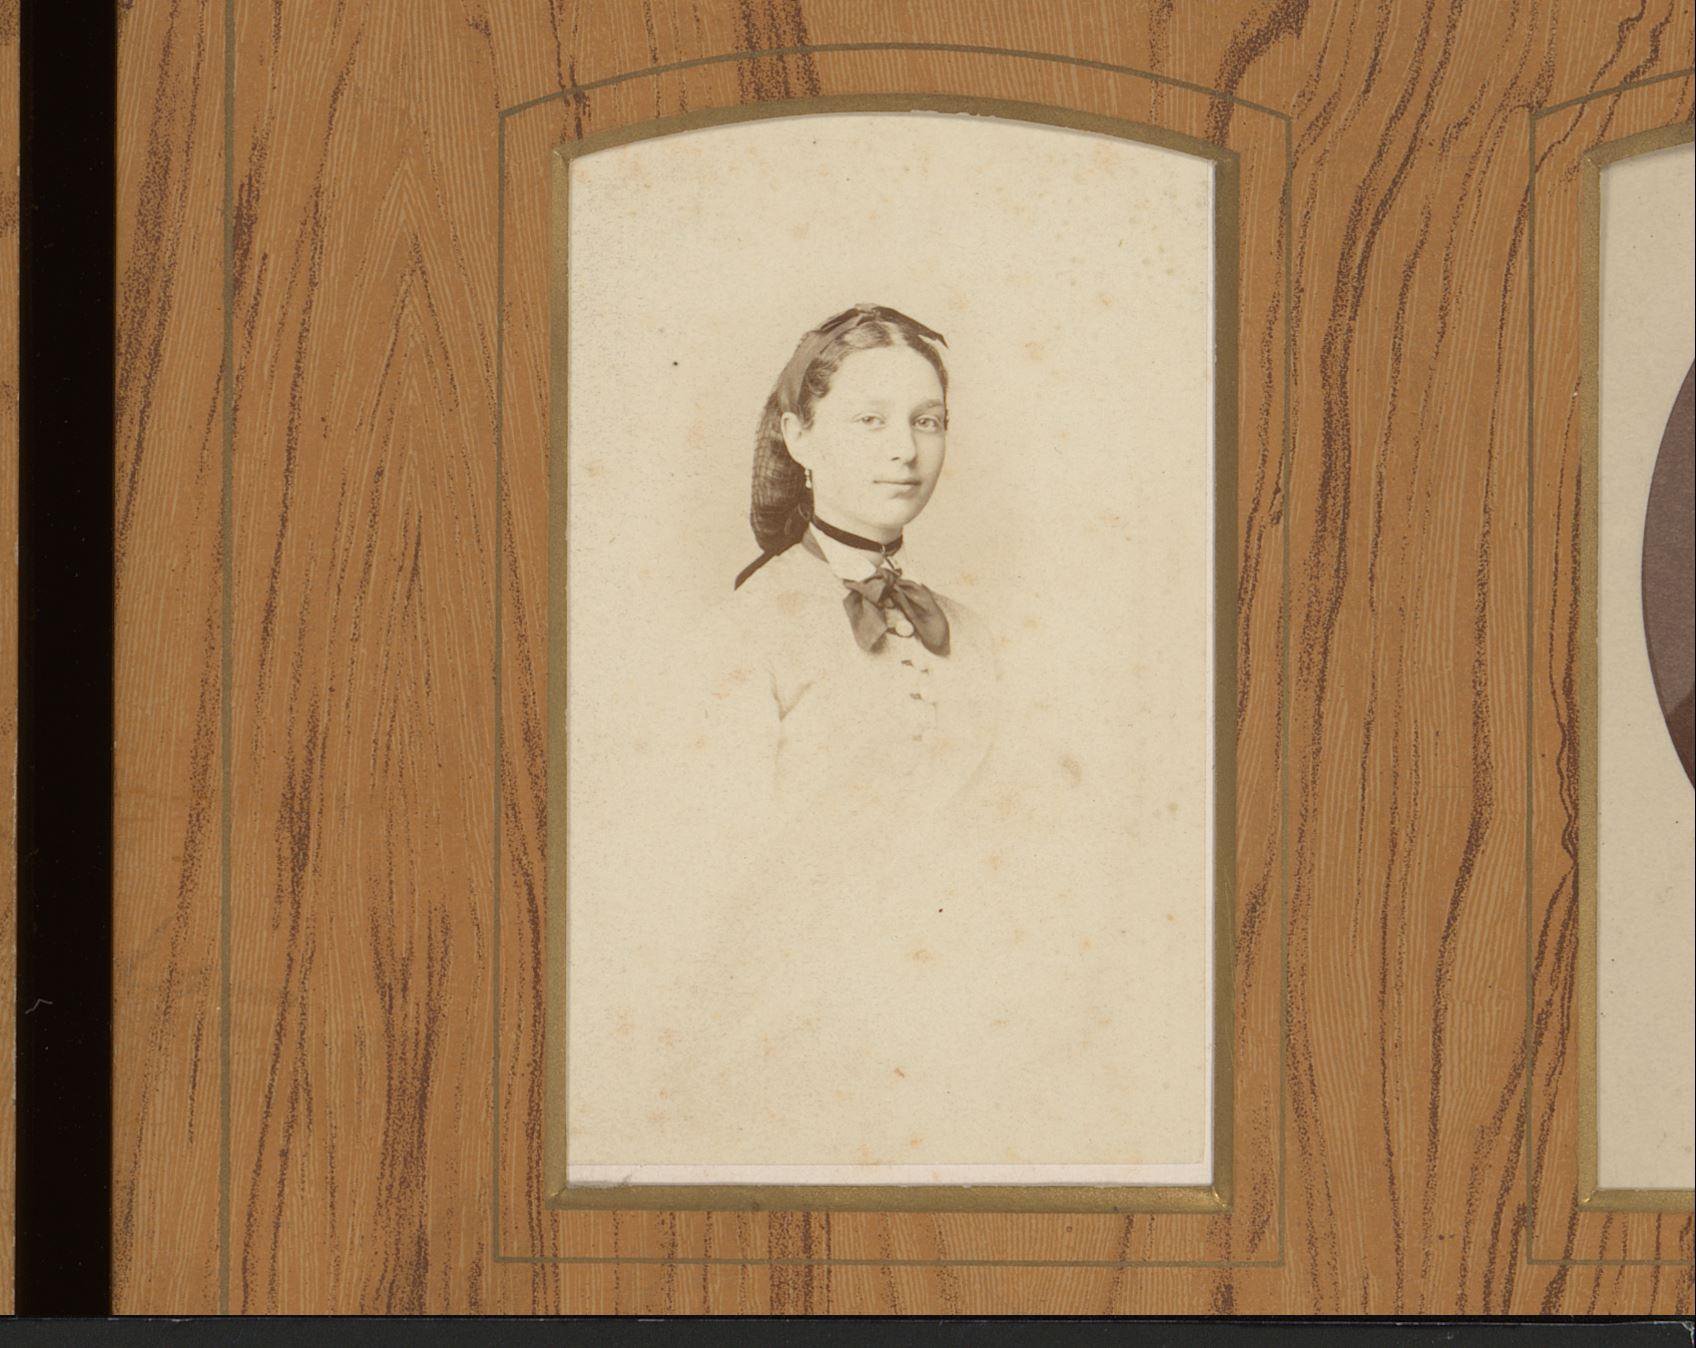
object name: carte de visite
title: Portret van een vrouw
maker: tony rouge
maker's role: fotograaf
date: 1850-1900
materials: cardboard, photographic support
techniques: albumen print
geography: paris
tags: historical persons - bb - woman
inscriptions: inscription: ‘MAISON V. PLUMIER/ TONY ROUGE/ Successeur,/ 36, Rue Vivienne/ PARIS/ AVIS IMPORTANT/ Tous les cliches sont conservés et peuvent donner/ des épreuves agrandies jusqu'a la grandeur/ nature sans avoir à poser de nouveau.’